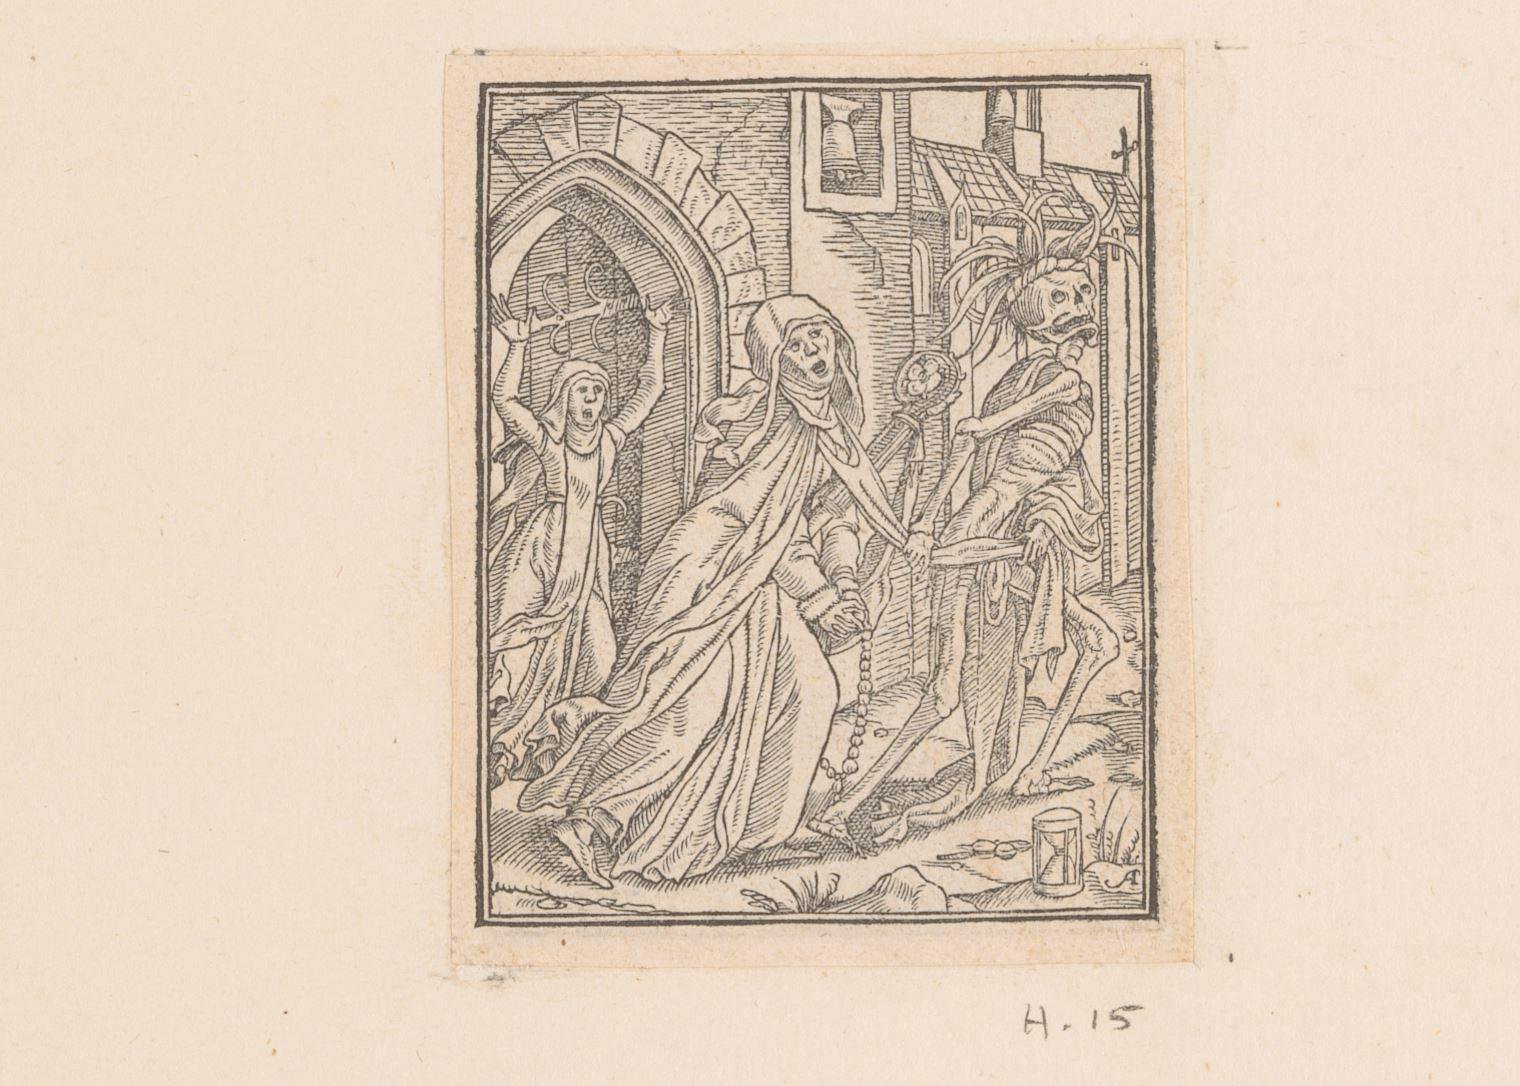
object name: print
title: Abdis met de Dood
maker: Anonymous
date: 1547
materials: paper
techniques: woodcut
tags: dance of death; death together with one or more human beings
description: Kopie van een prent van Hans Holbein de jongere uit 1538, voor het eerst gepubliceerd in: Imagines mortis (...). Lyon: Johannes Frellon, 1547.